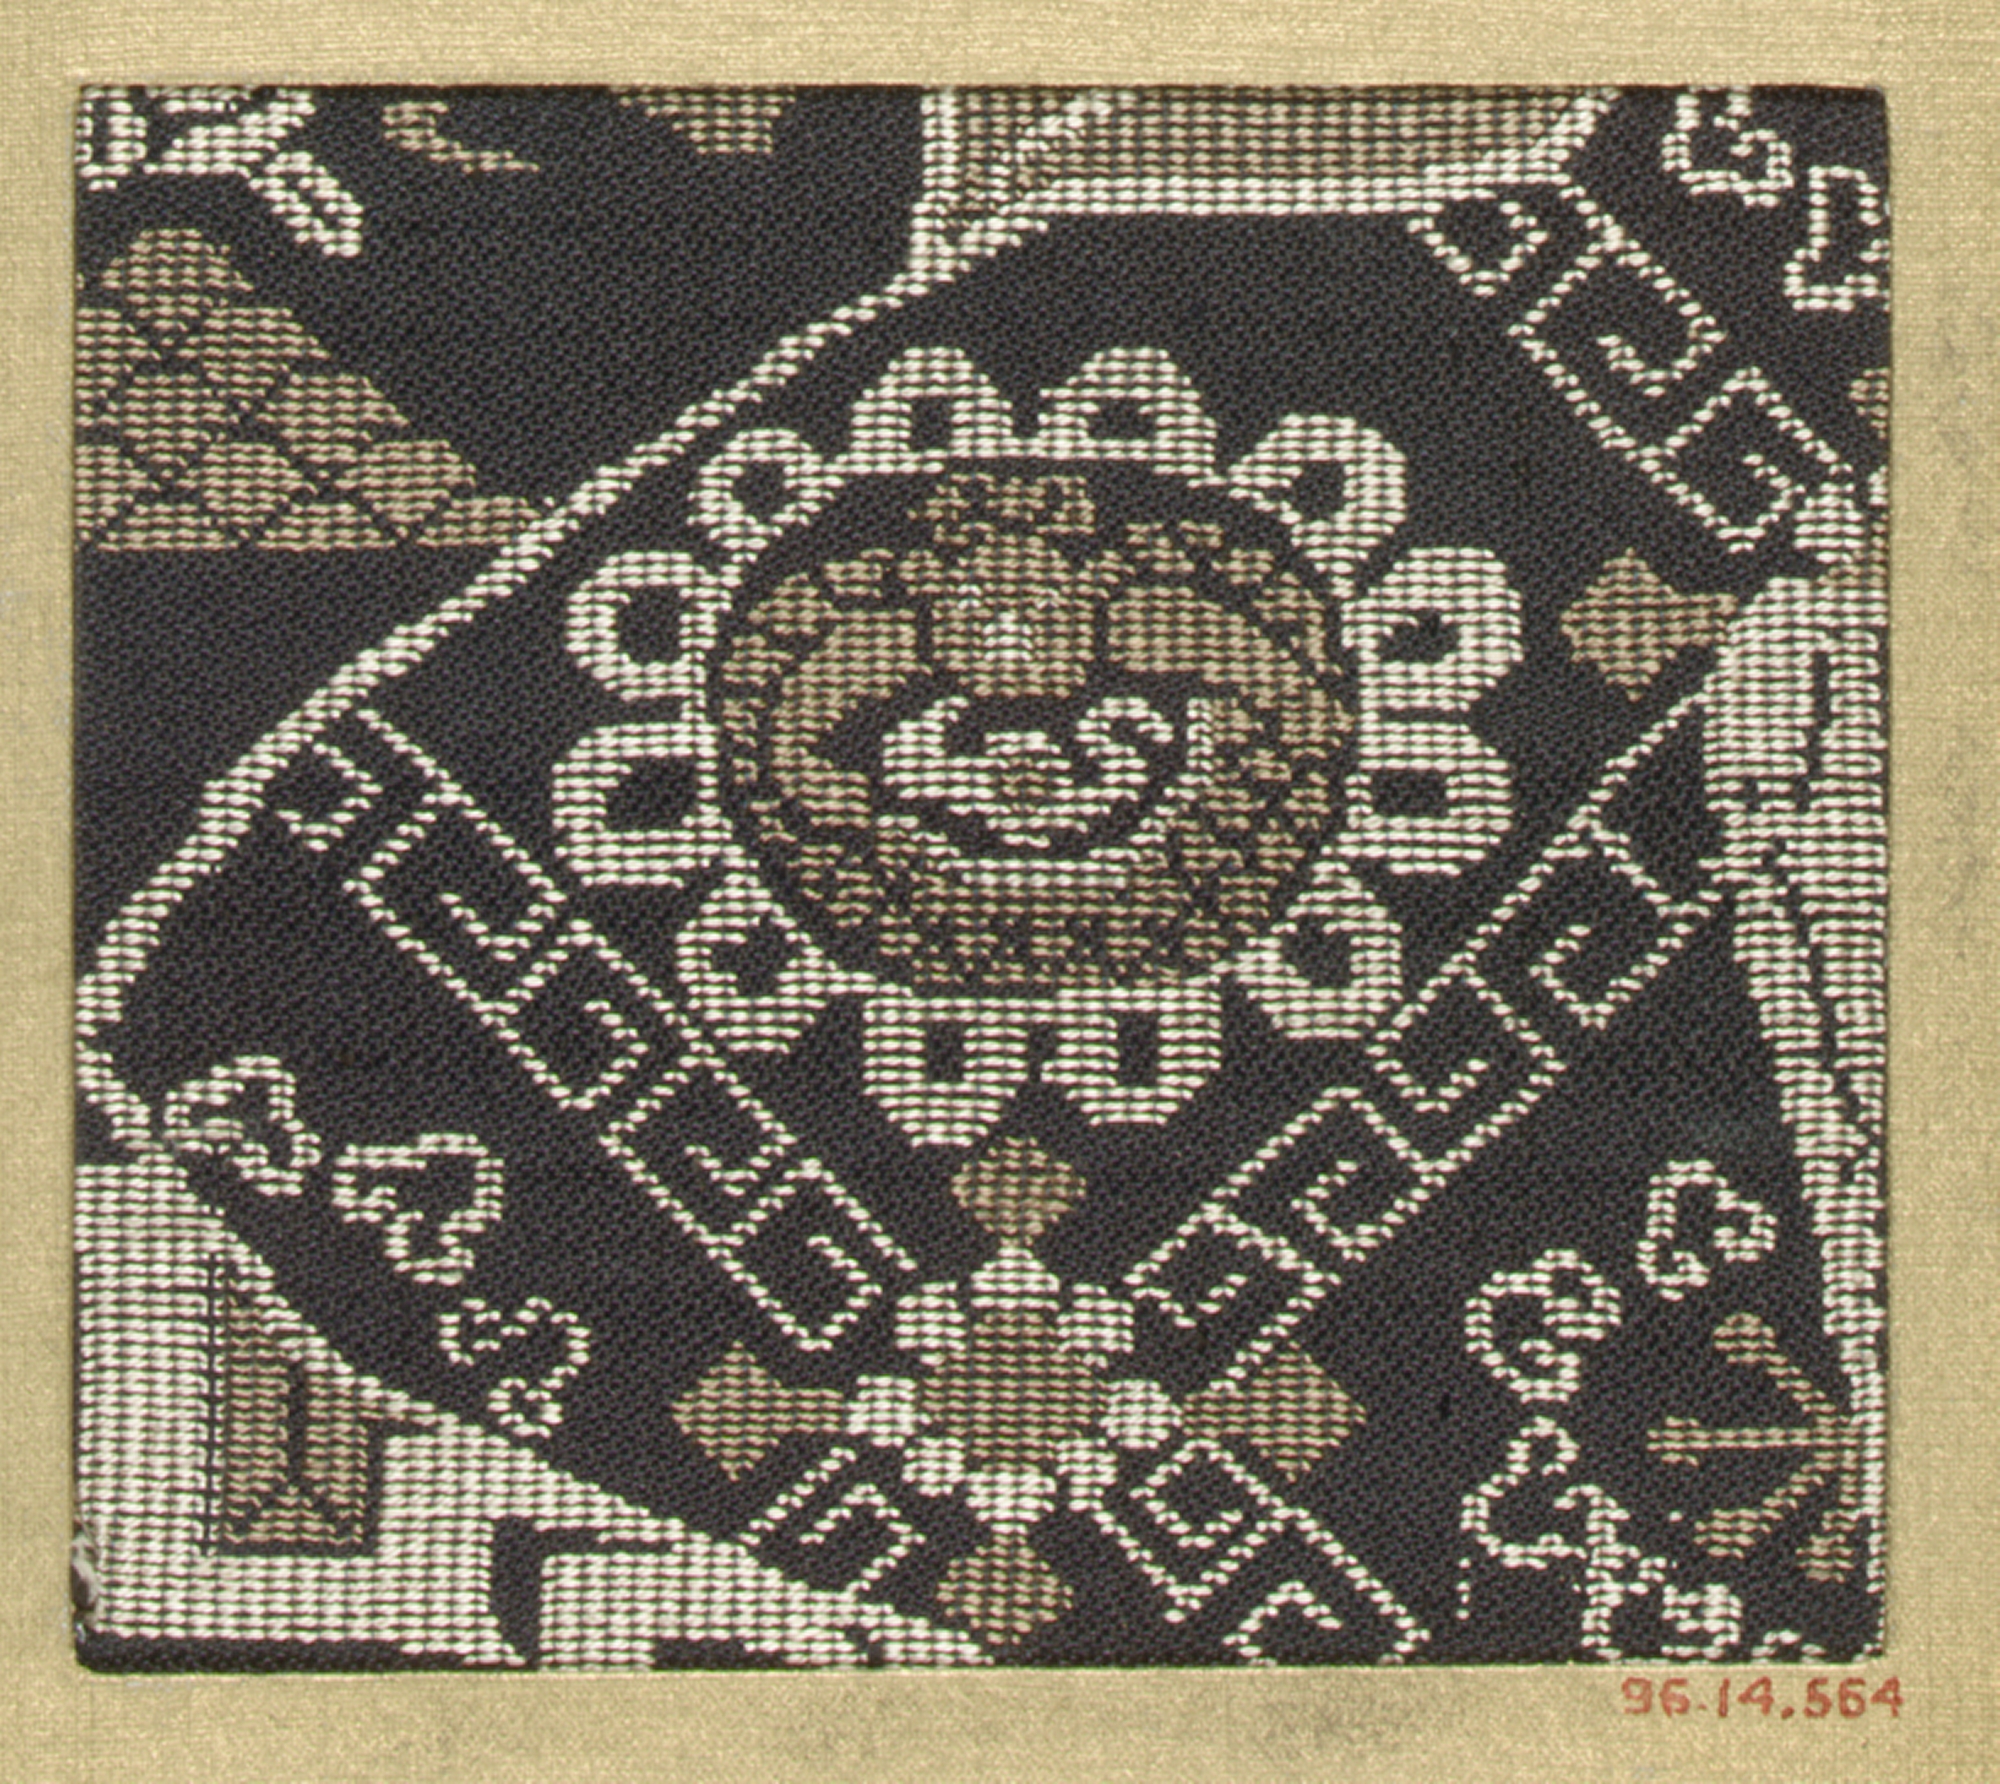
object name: piece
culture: japanese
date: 1701-1900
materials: silk